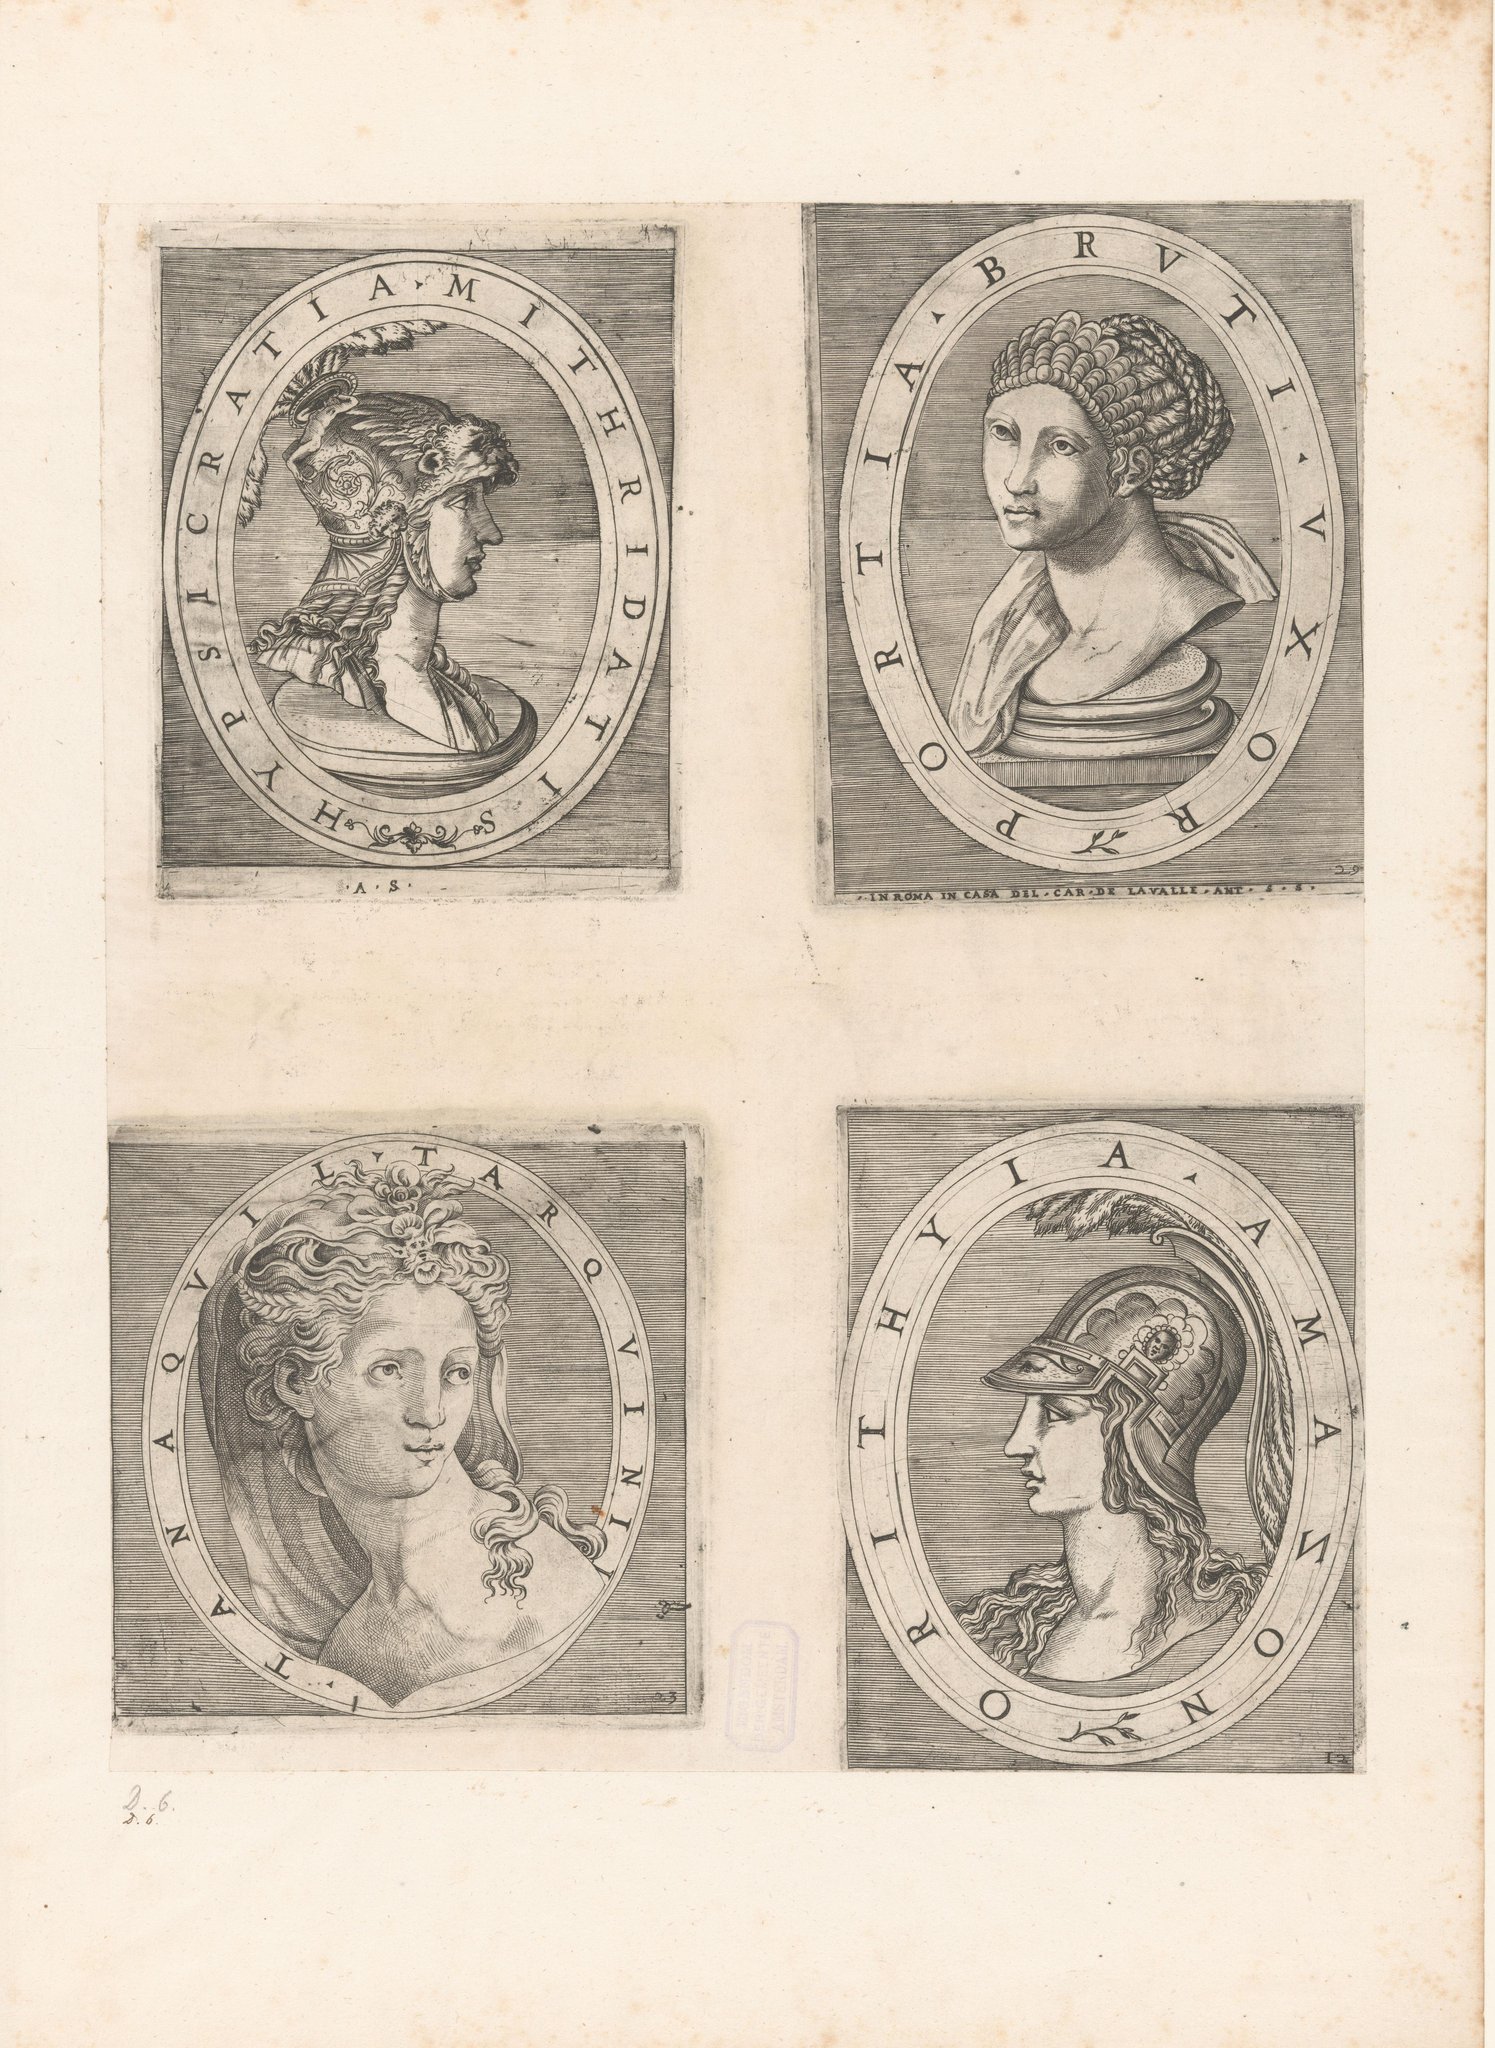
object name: print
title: Vier vrouwenkoppen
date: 1510-1562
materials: paper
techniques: engraving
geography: italy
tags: historical persons - bb - woman, piece of sculpture, reproduction of a piece of sculpture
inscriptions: collector's mark: Lugt 11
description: Blad met vier voorstellingen van medaillons met vrouwenkoppen. Linksboven: portretbuste van Hypsicratia Mithridatis. Genummerd rechtsonder: 3. Rechtsboven: portretbuste van Portia Bruti Uxor. Genummerd rechtsonder: 29. Linksonder: Tanaquil Tarquinii. Genummerd rechtsonder: 23. Rechtsonder: Orithyia Amazon. Genummerd rechtsonder: 12.